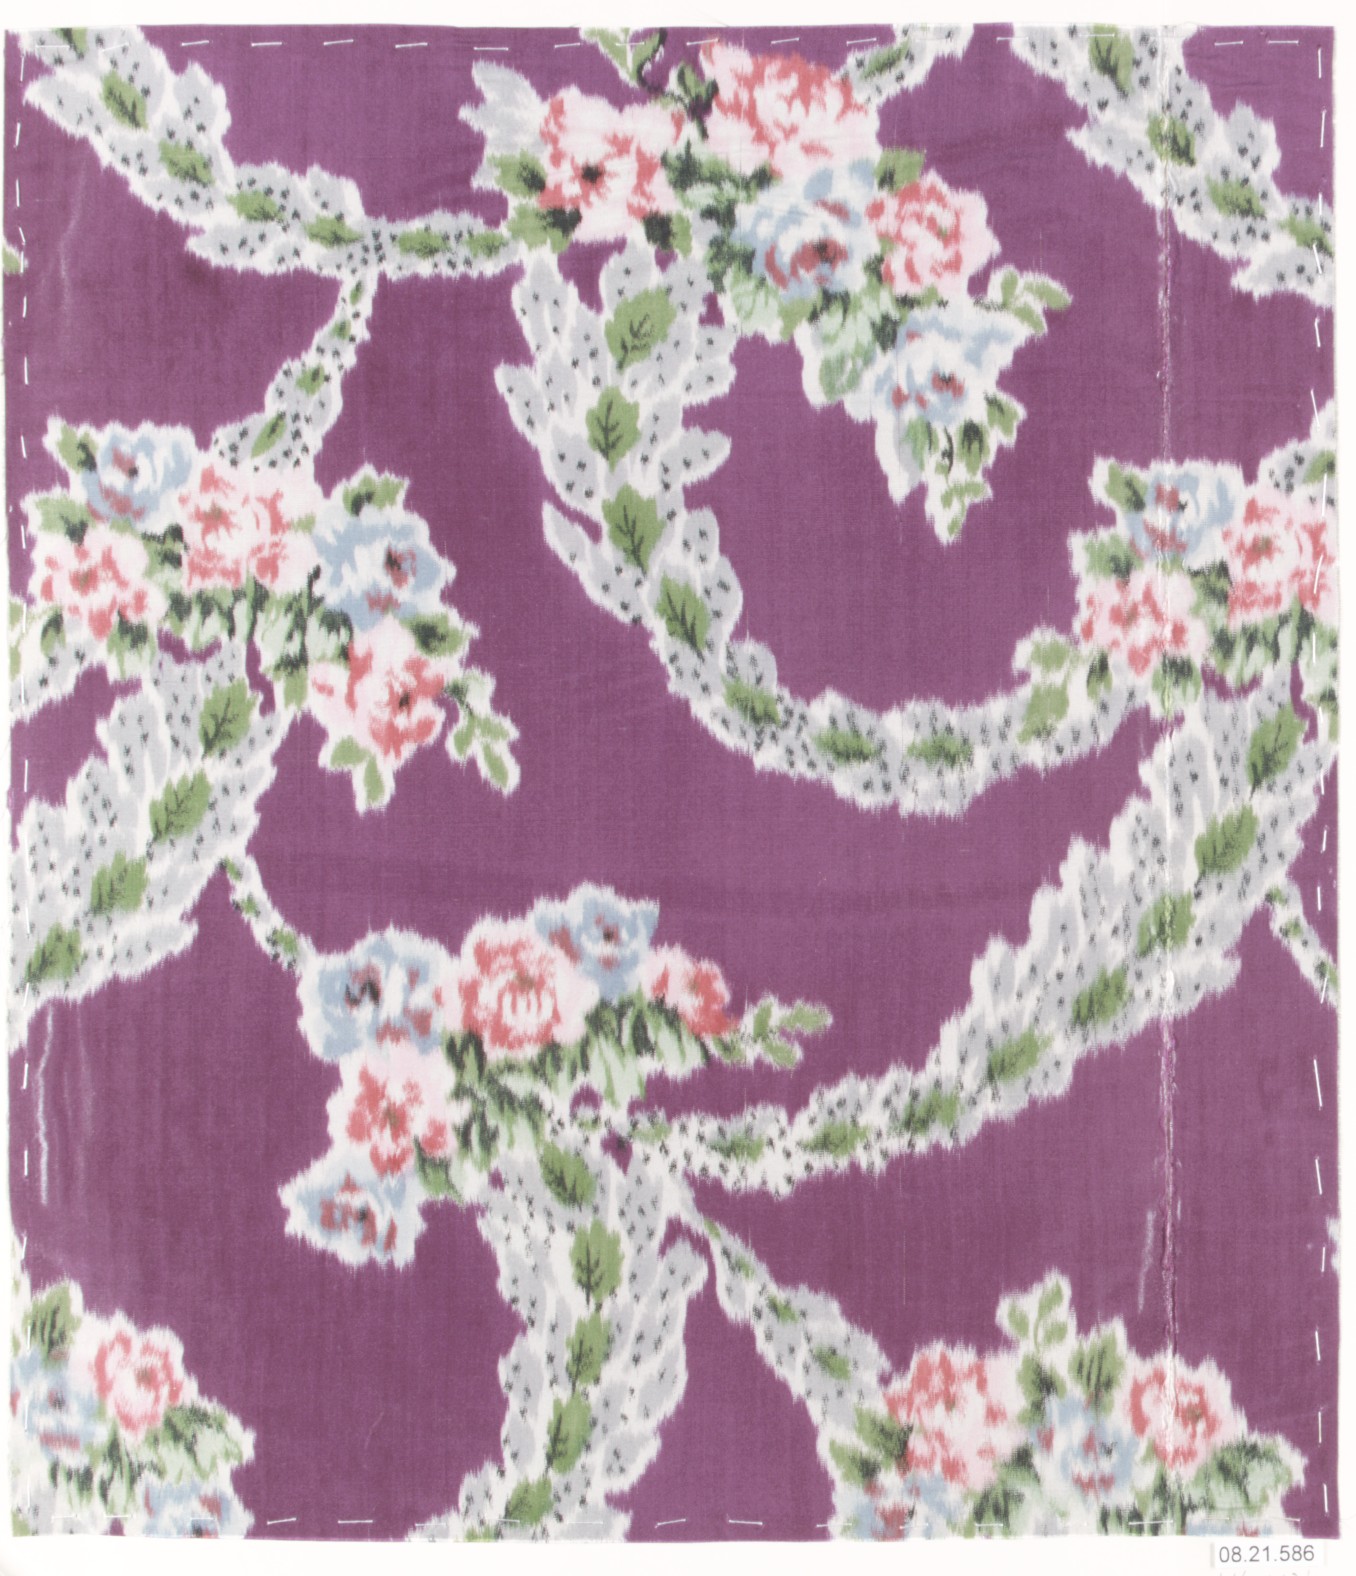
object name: textile sample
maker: Anonymous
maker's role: designer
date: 1900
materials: silk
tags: flowers,leaves